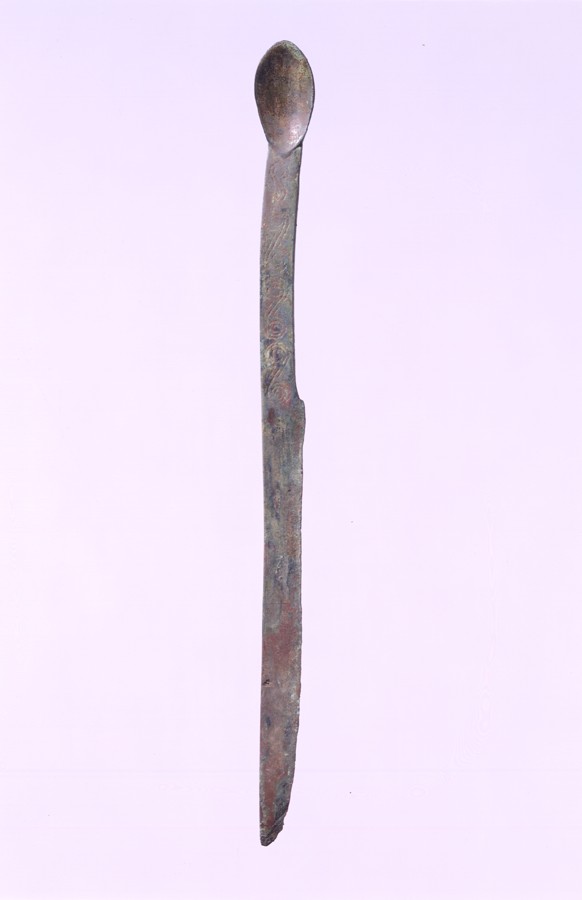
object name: knife spoon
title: Knife-Spoon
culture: chinese, northeast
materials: bronze